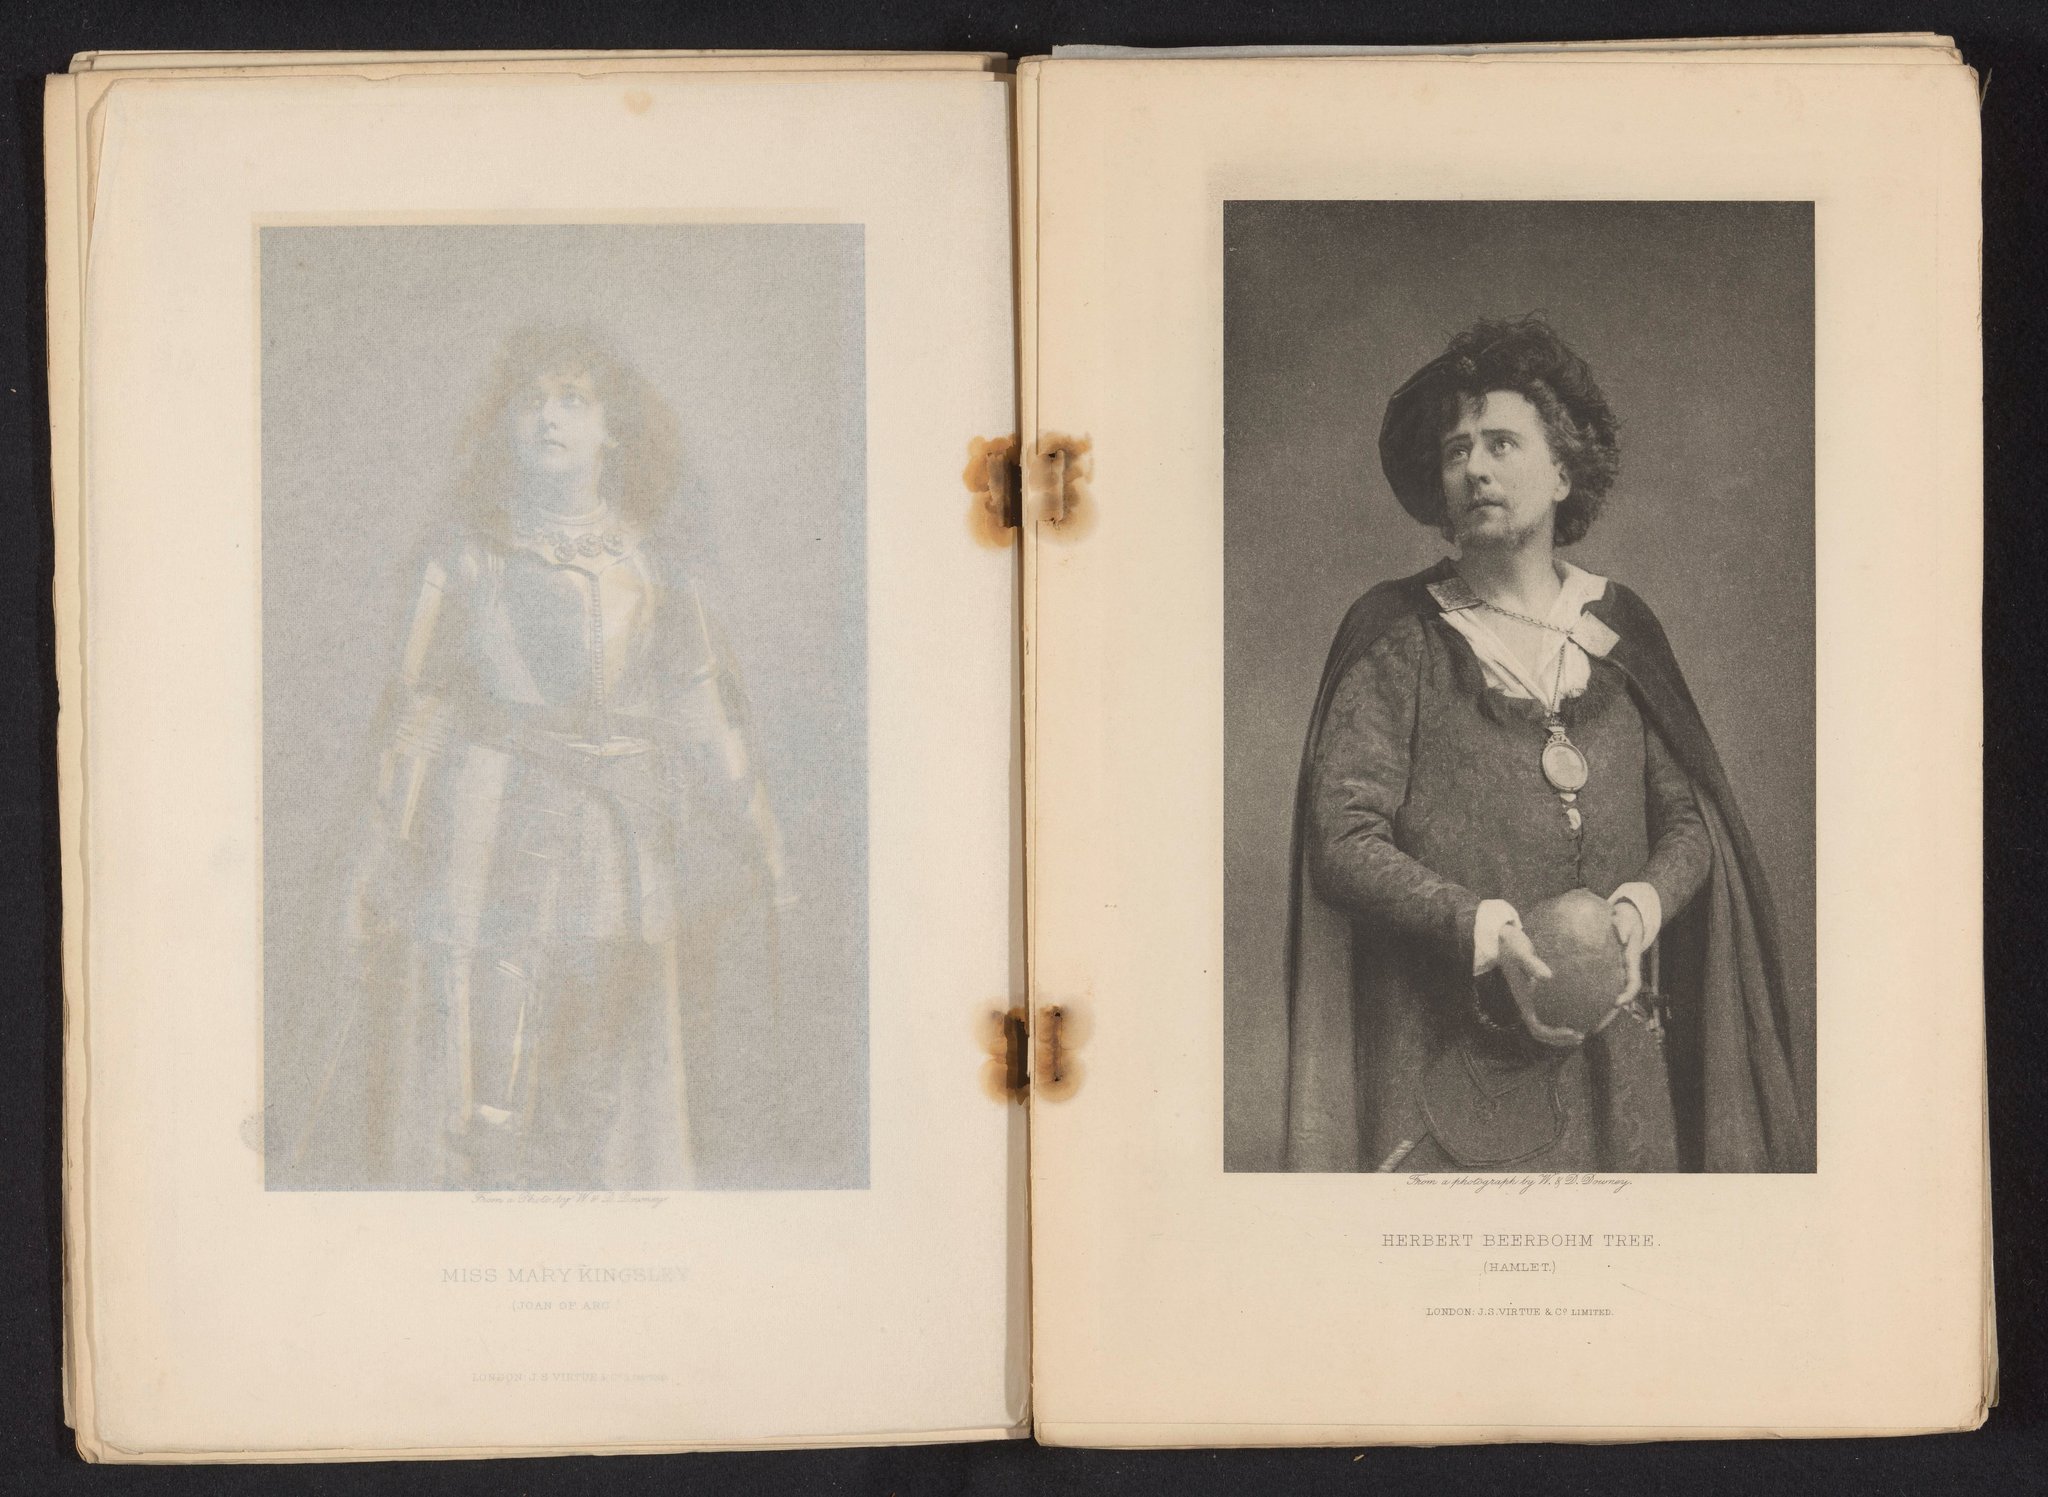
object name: photomechanical print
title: Herbert Beerbohm Tree (Hamlet)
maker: Anonymous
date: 1880-1890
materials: paper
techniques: photoaquatint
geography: london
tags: portrait of actor, actress